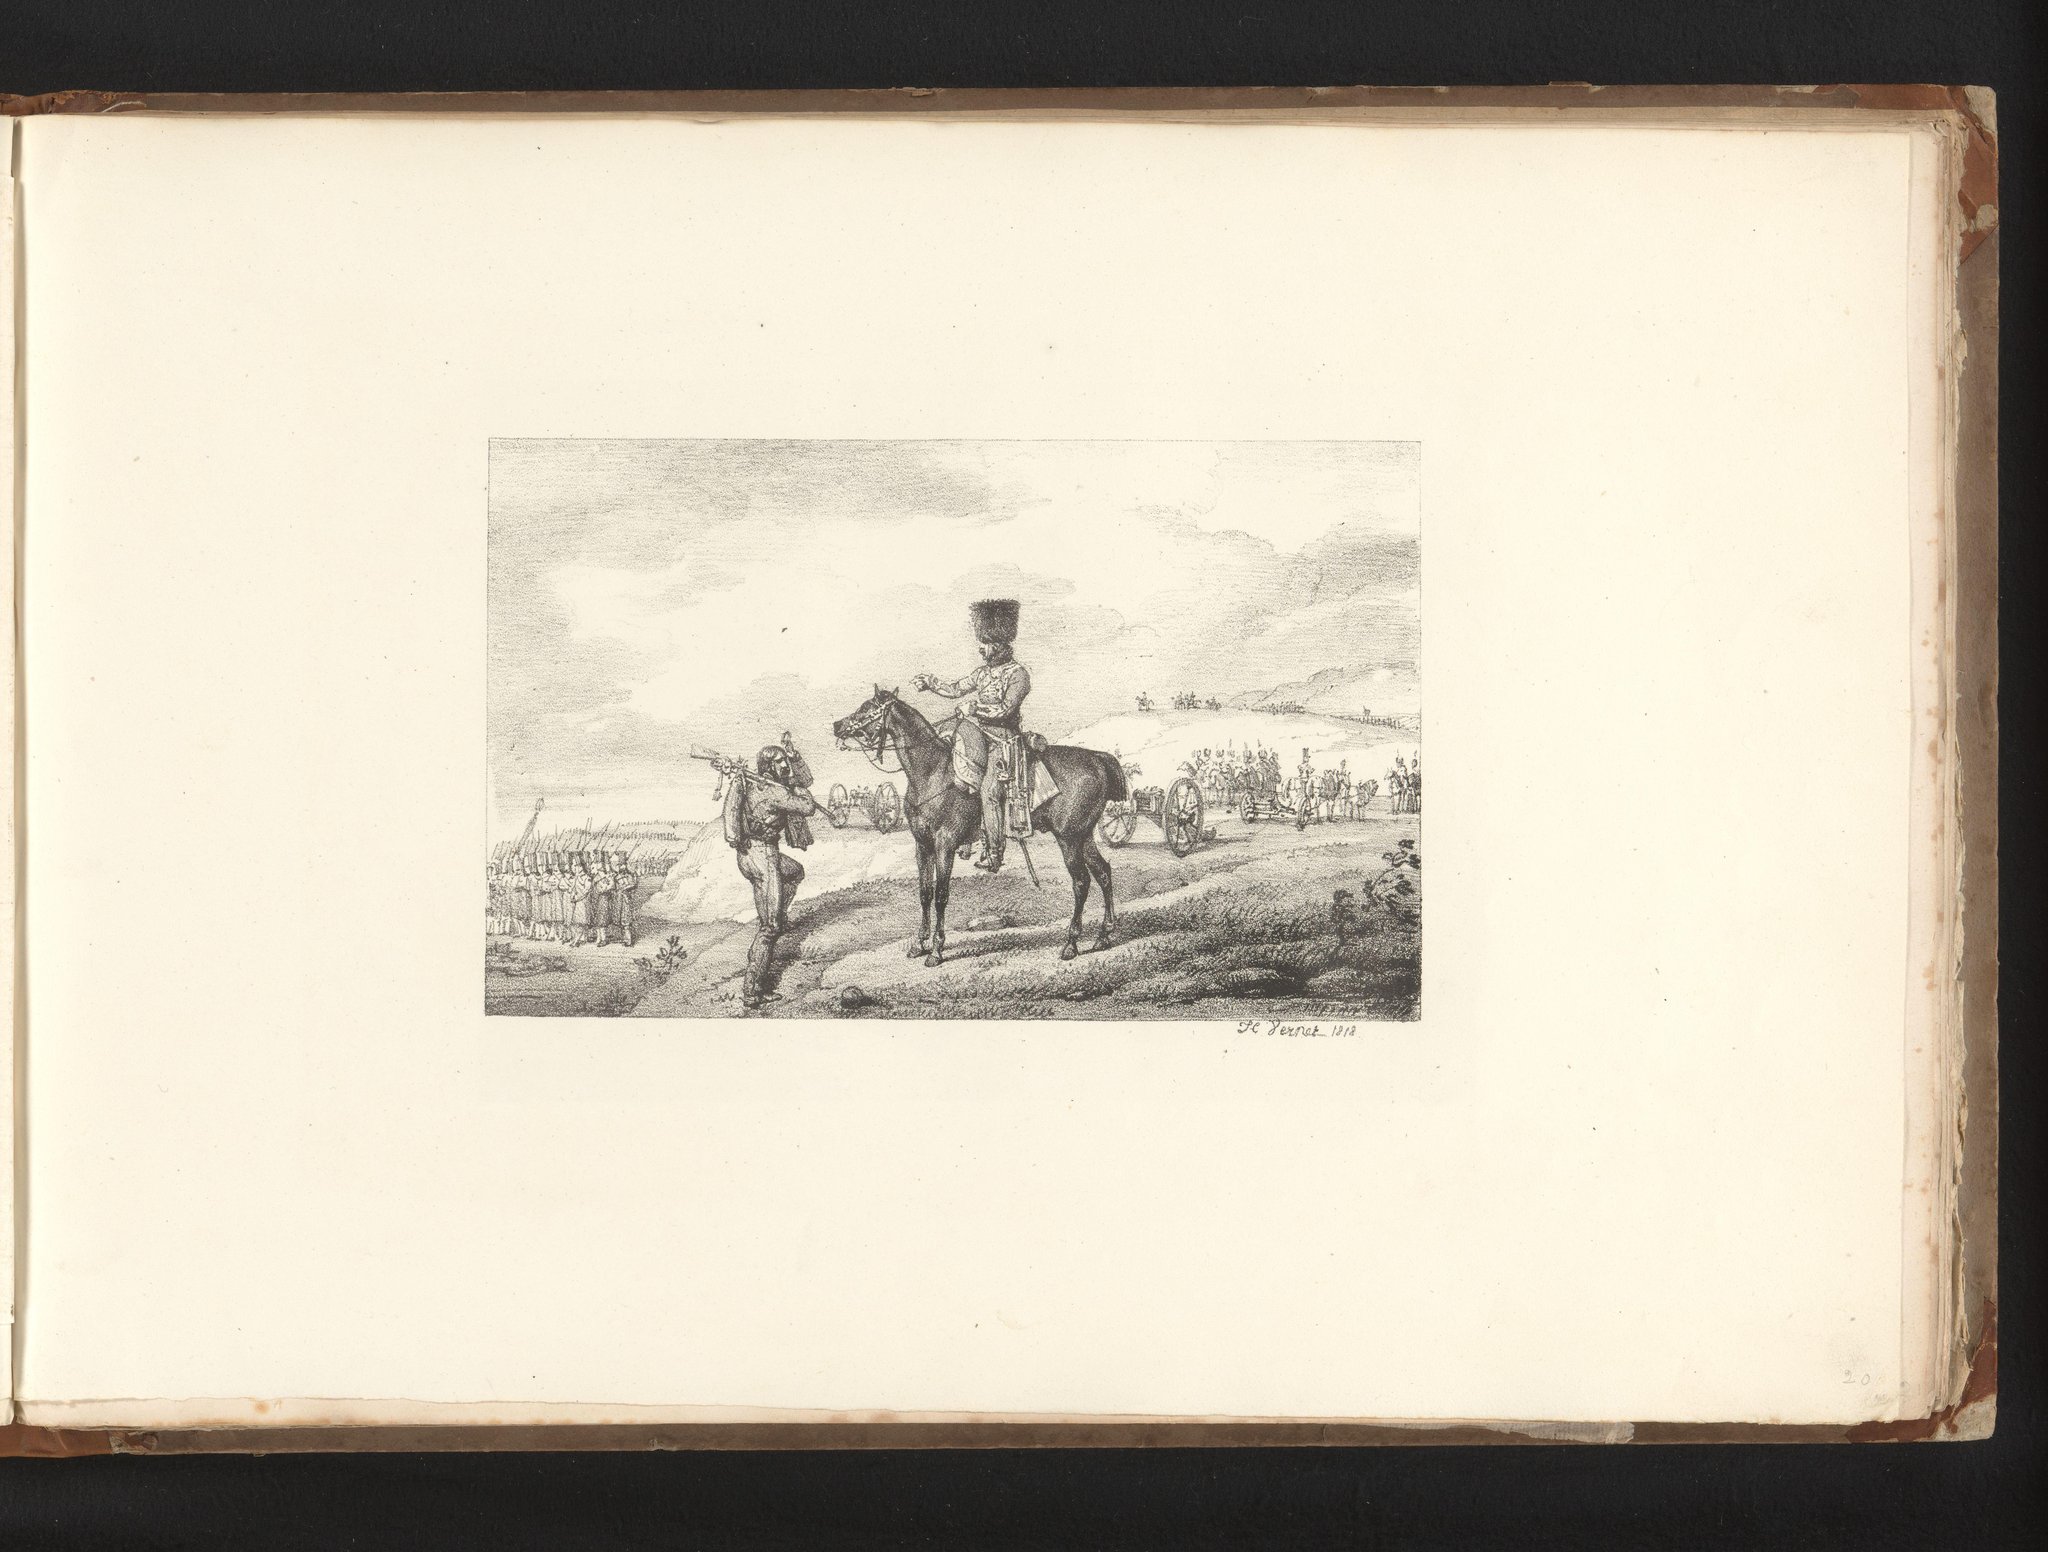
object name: print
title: Serie lithografieën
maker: horace vernet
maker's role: draughtsman, painter, print maker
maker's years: 1789-1863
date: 1818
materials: paper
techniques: lithograph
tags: the soldier; the soldier's life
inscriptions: date